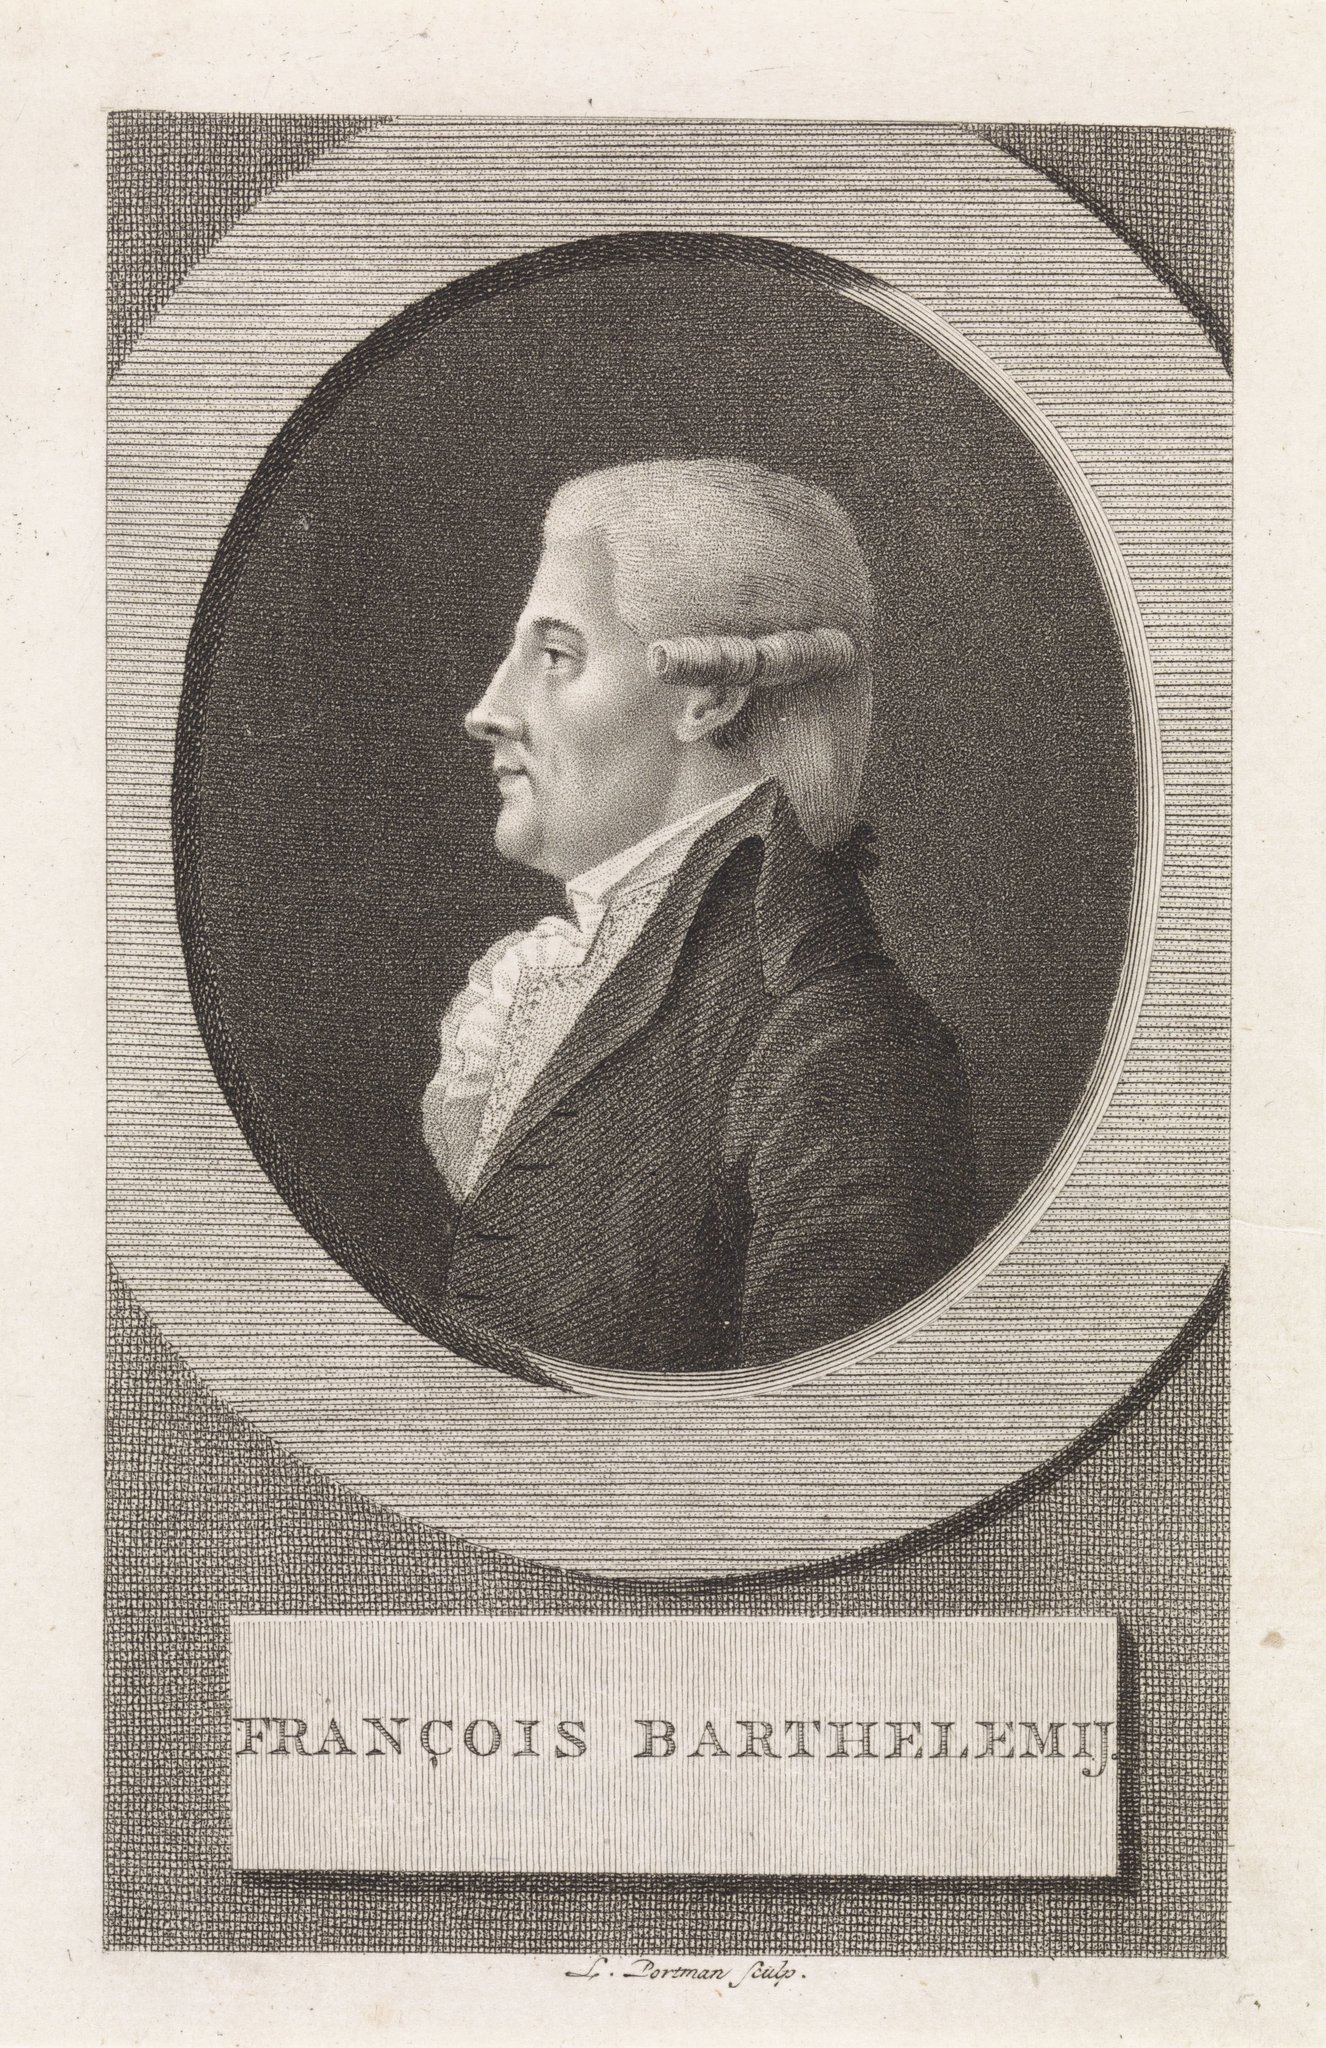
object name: print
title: Portret van de Franse diplomaat François Barthélemy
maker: ludwig gottlieb portman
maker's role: print maker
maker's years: 1772-1828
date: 1806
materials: paper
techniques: etching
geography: amsterdam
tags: aubagne, françois-marie markies van barthélemy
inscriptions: collector's mark: Lugt 2228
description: Prent ook gebruikt als illustratie in: Tafereelen van de staatsomwenteling in Frankrijk, deel 22, p. 132. Amsterdam: Johannes Allart, 1806.